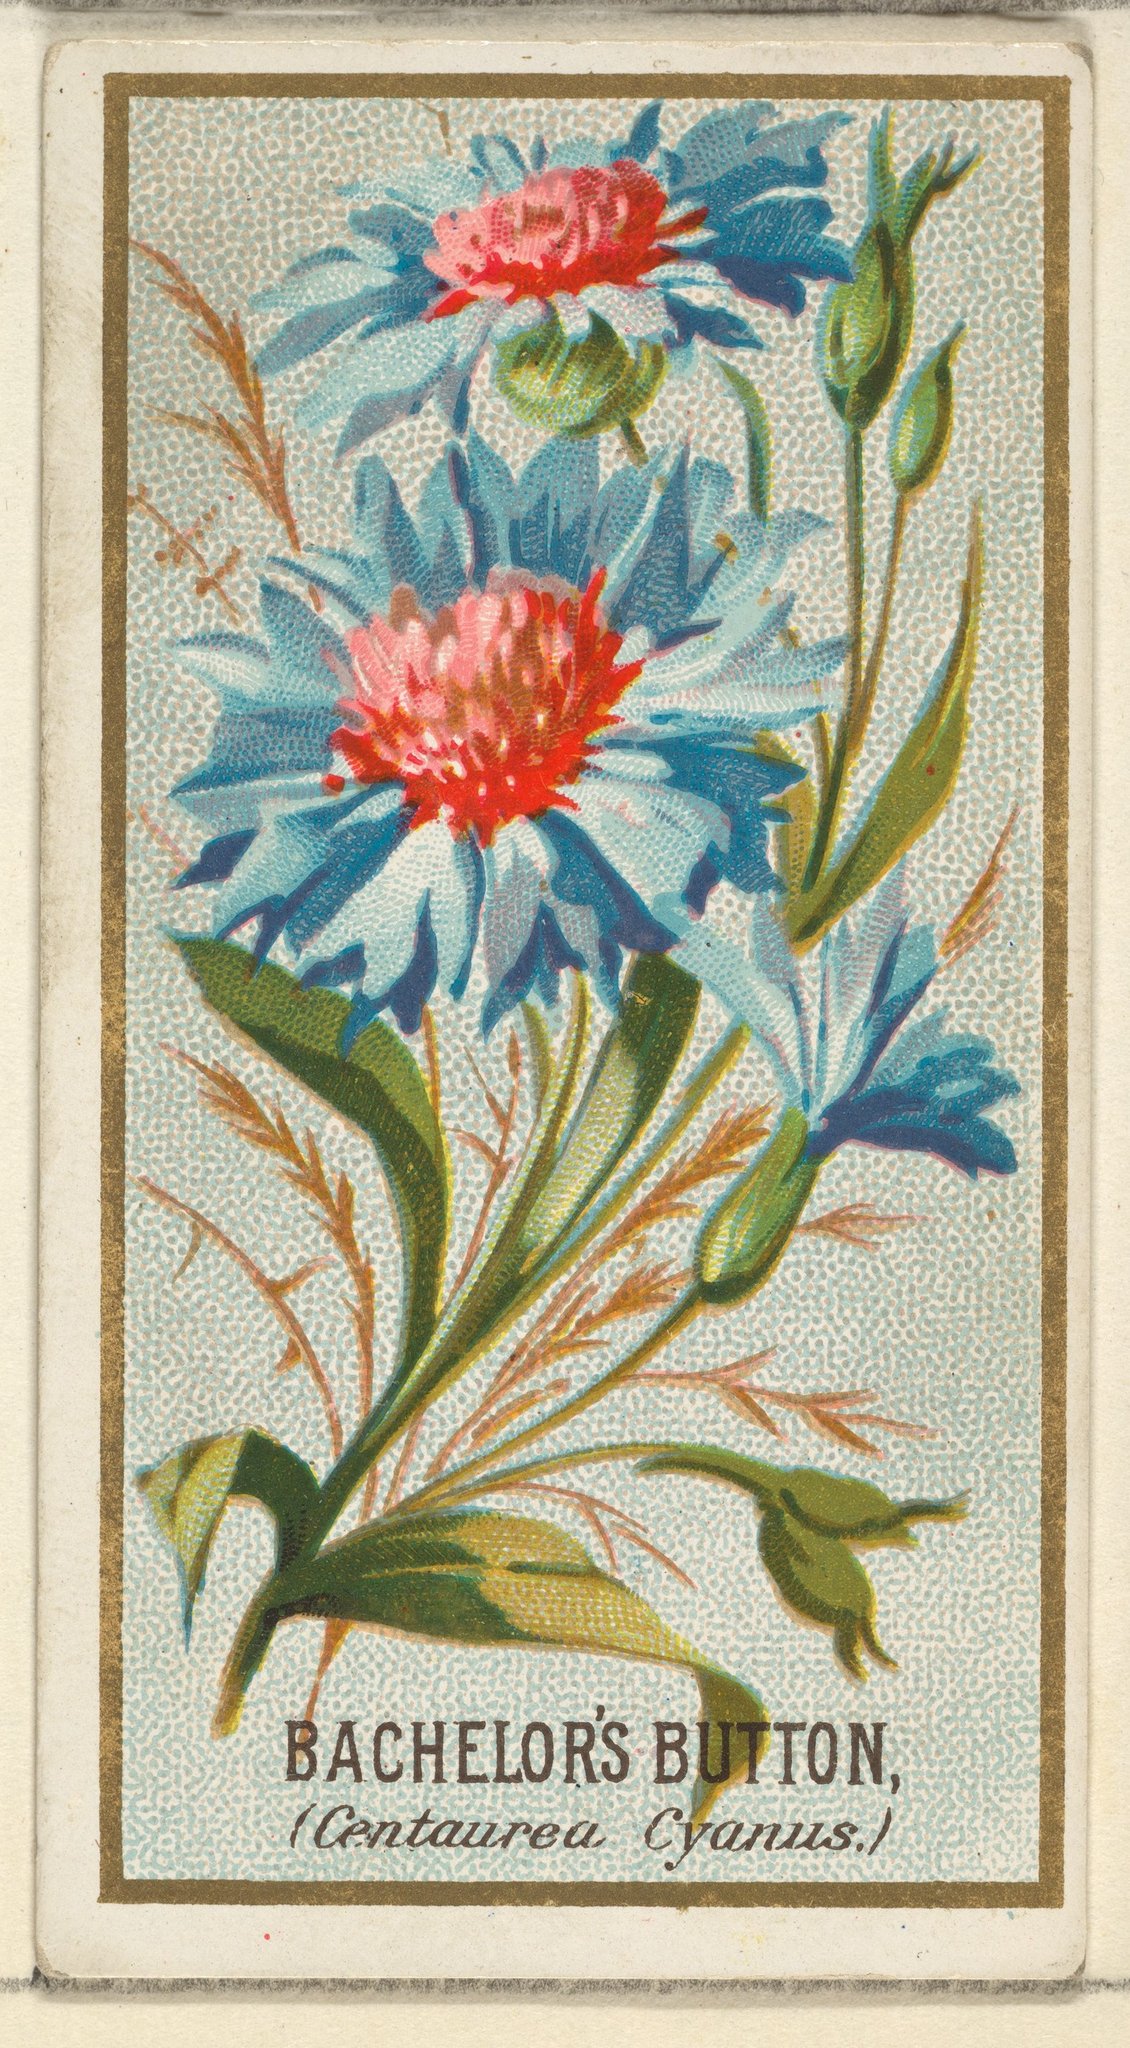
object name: print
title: Bachelor's Button (Centaurea Cyanus), from the Flowers series for Old Judge Cigarettes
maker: goodwin & company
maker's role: publisher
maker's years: 1850-1950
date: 1890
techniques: color lithograph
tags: flowers,leaves